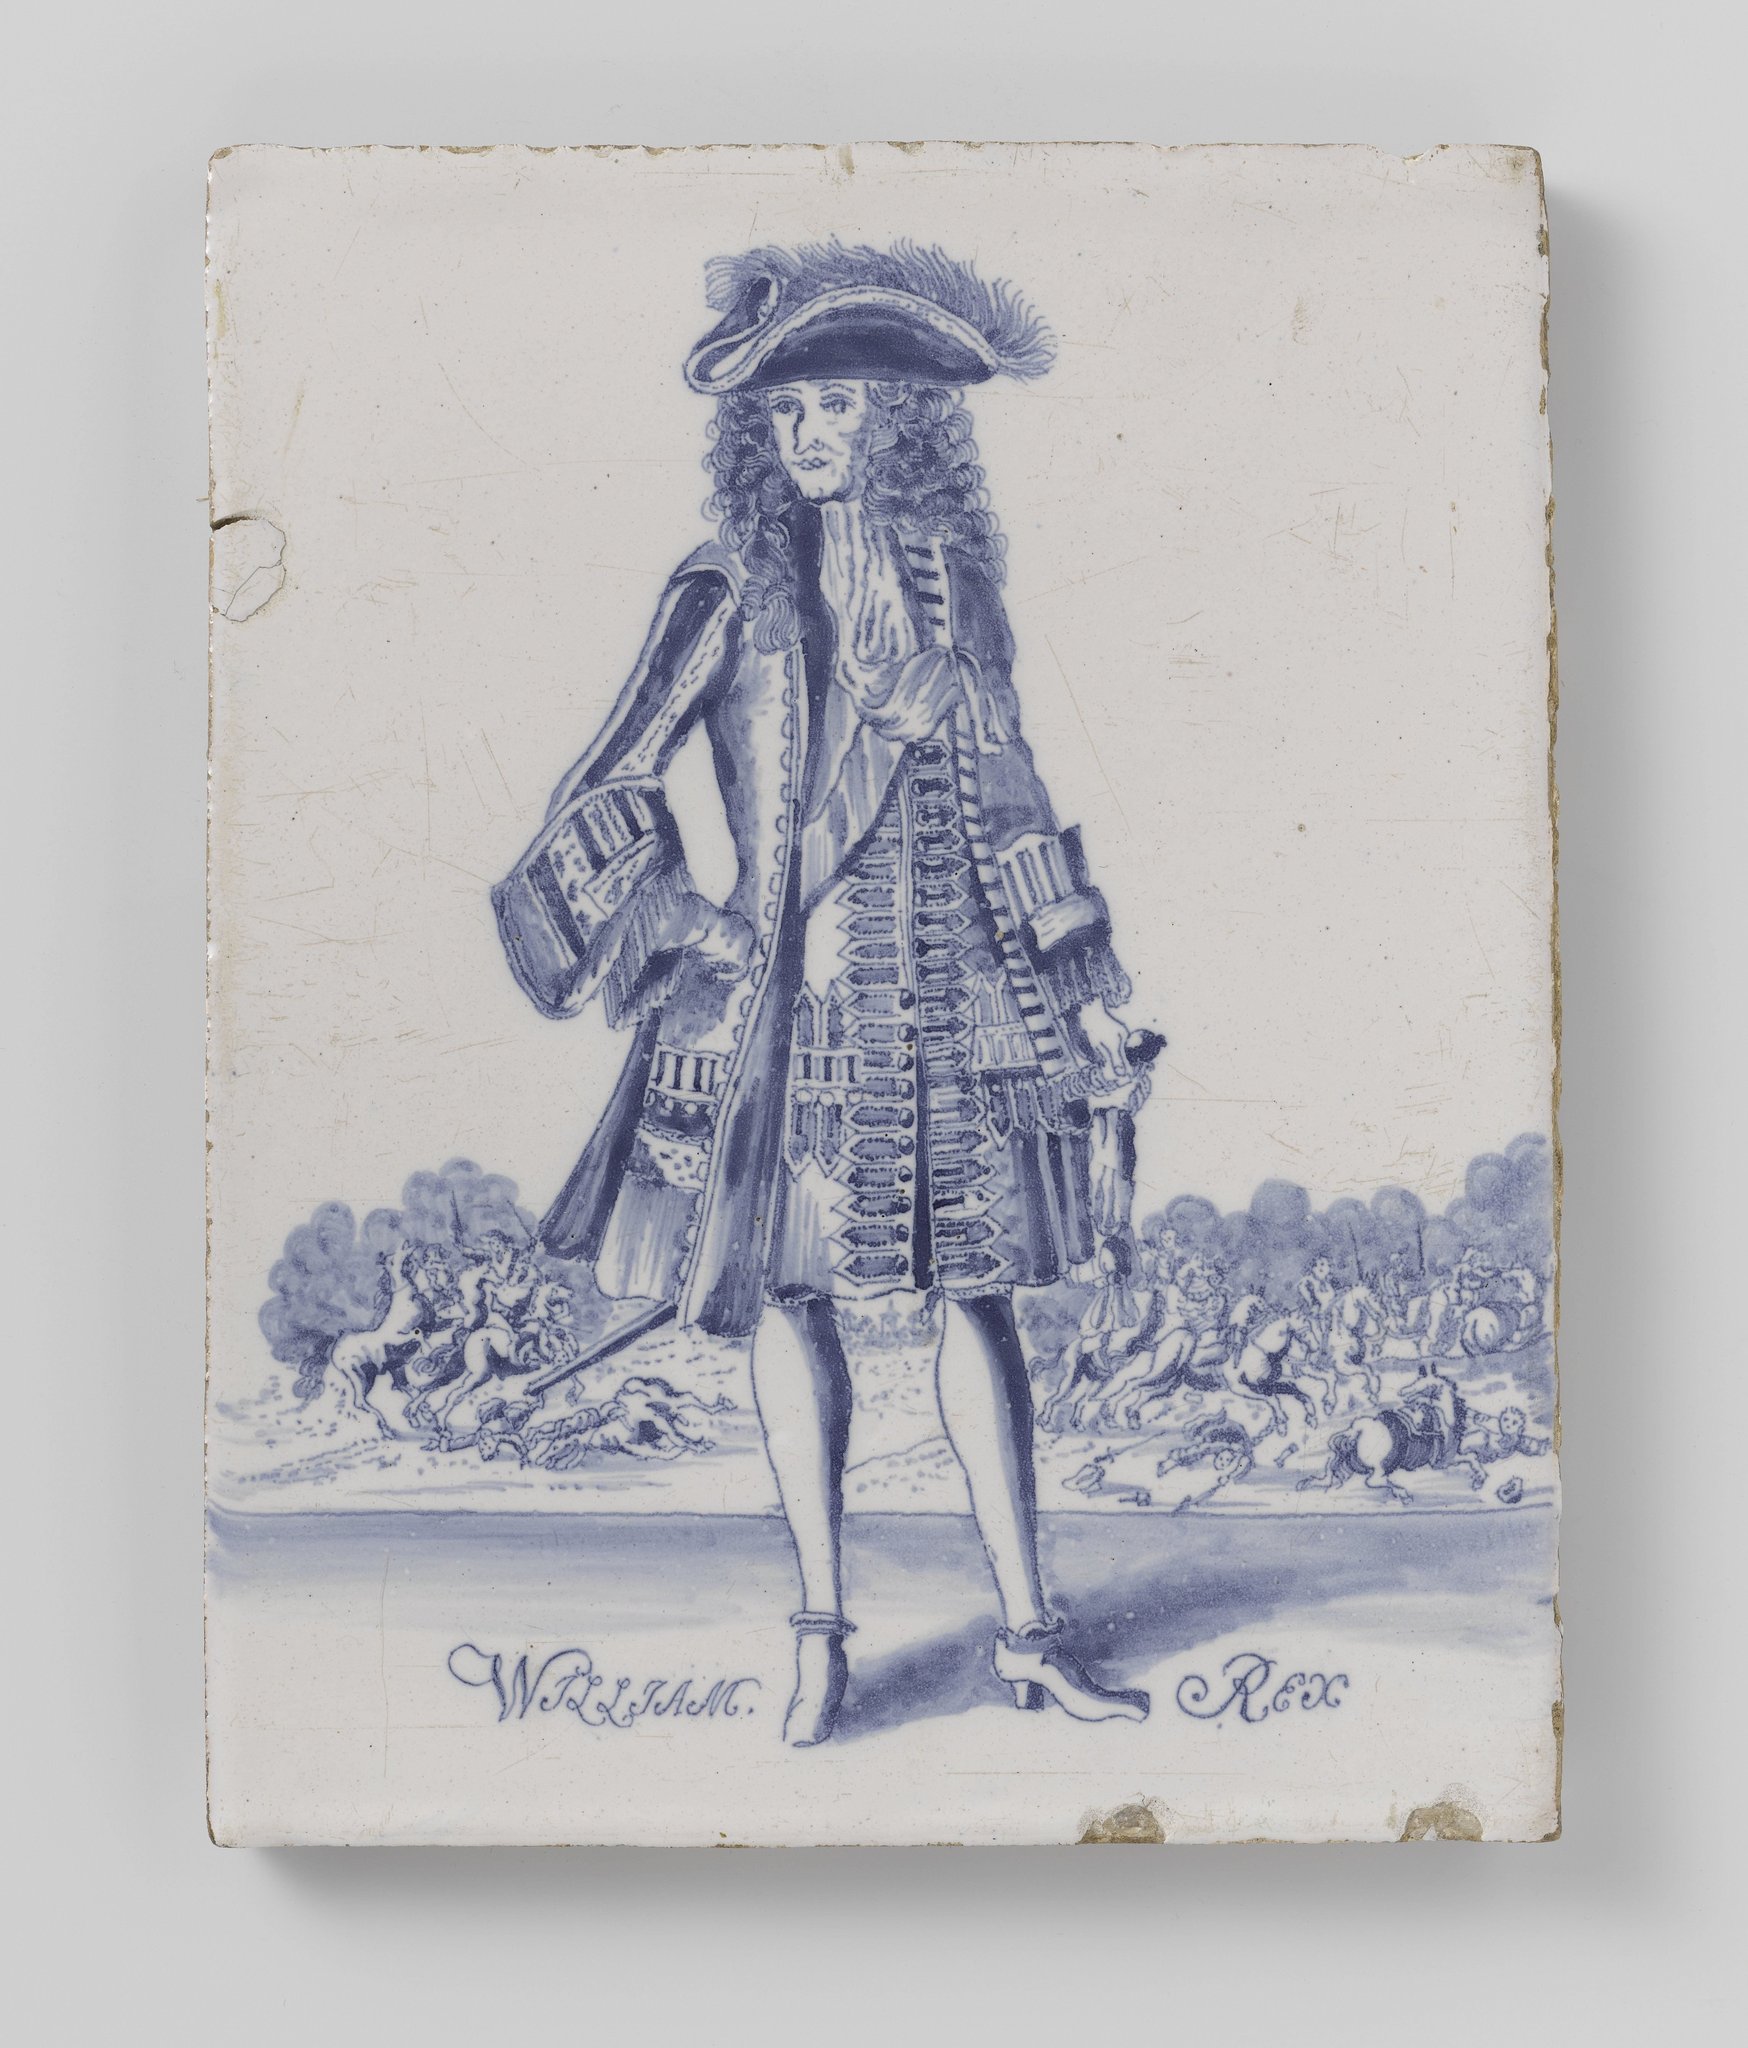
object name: plate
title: Koning-Stadhouder Willem III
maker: Anonymous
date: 1680-1700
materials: earthenware, glaze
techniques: painted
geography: delft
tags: the hague, william iii (prince of orange and king of england, scotland, and ireland)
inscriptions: inscription: ‘William Rex’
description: Tile with picture of stadholder-king William III. Delftware, late 17th century. A cavalry battle is shown in the background.